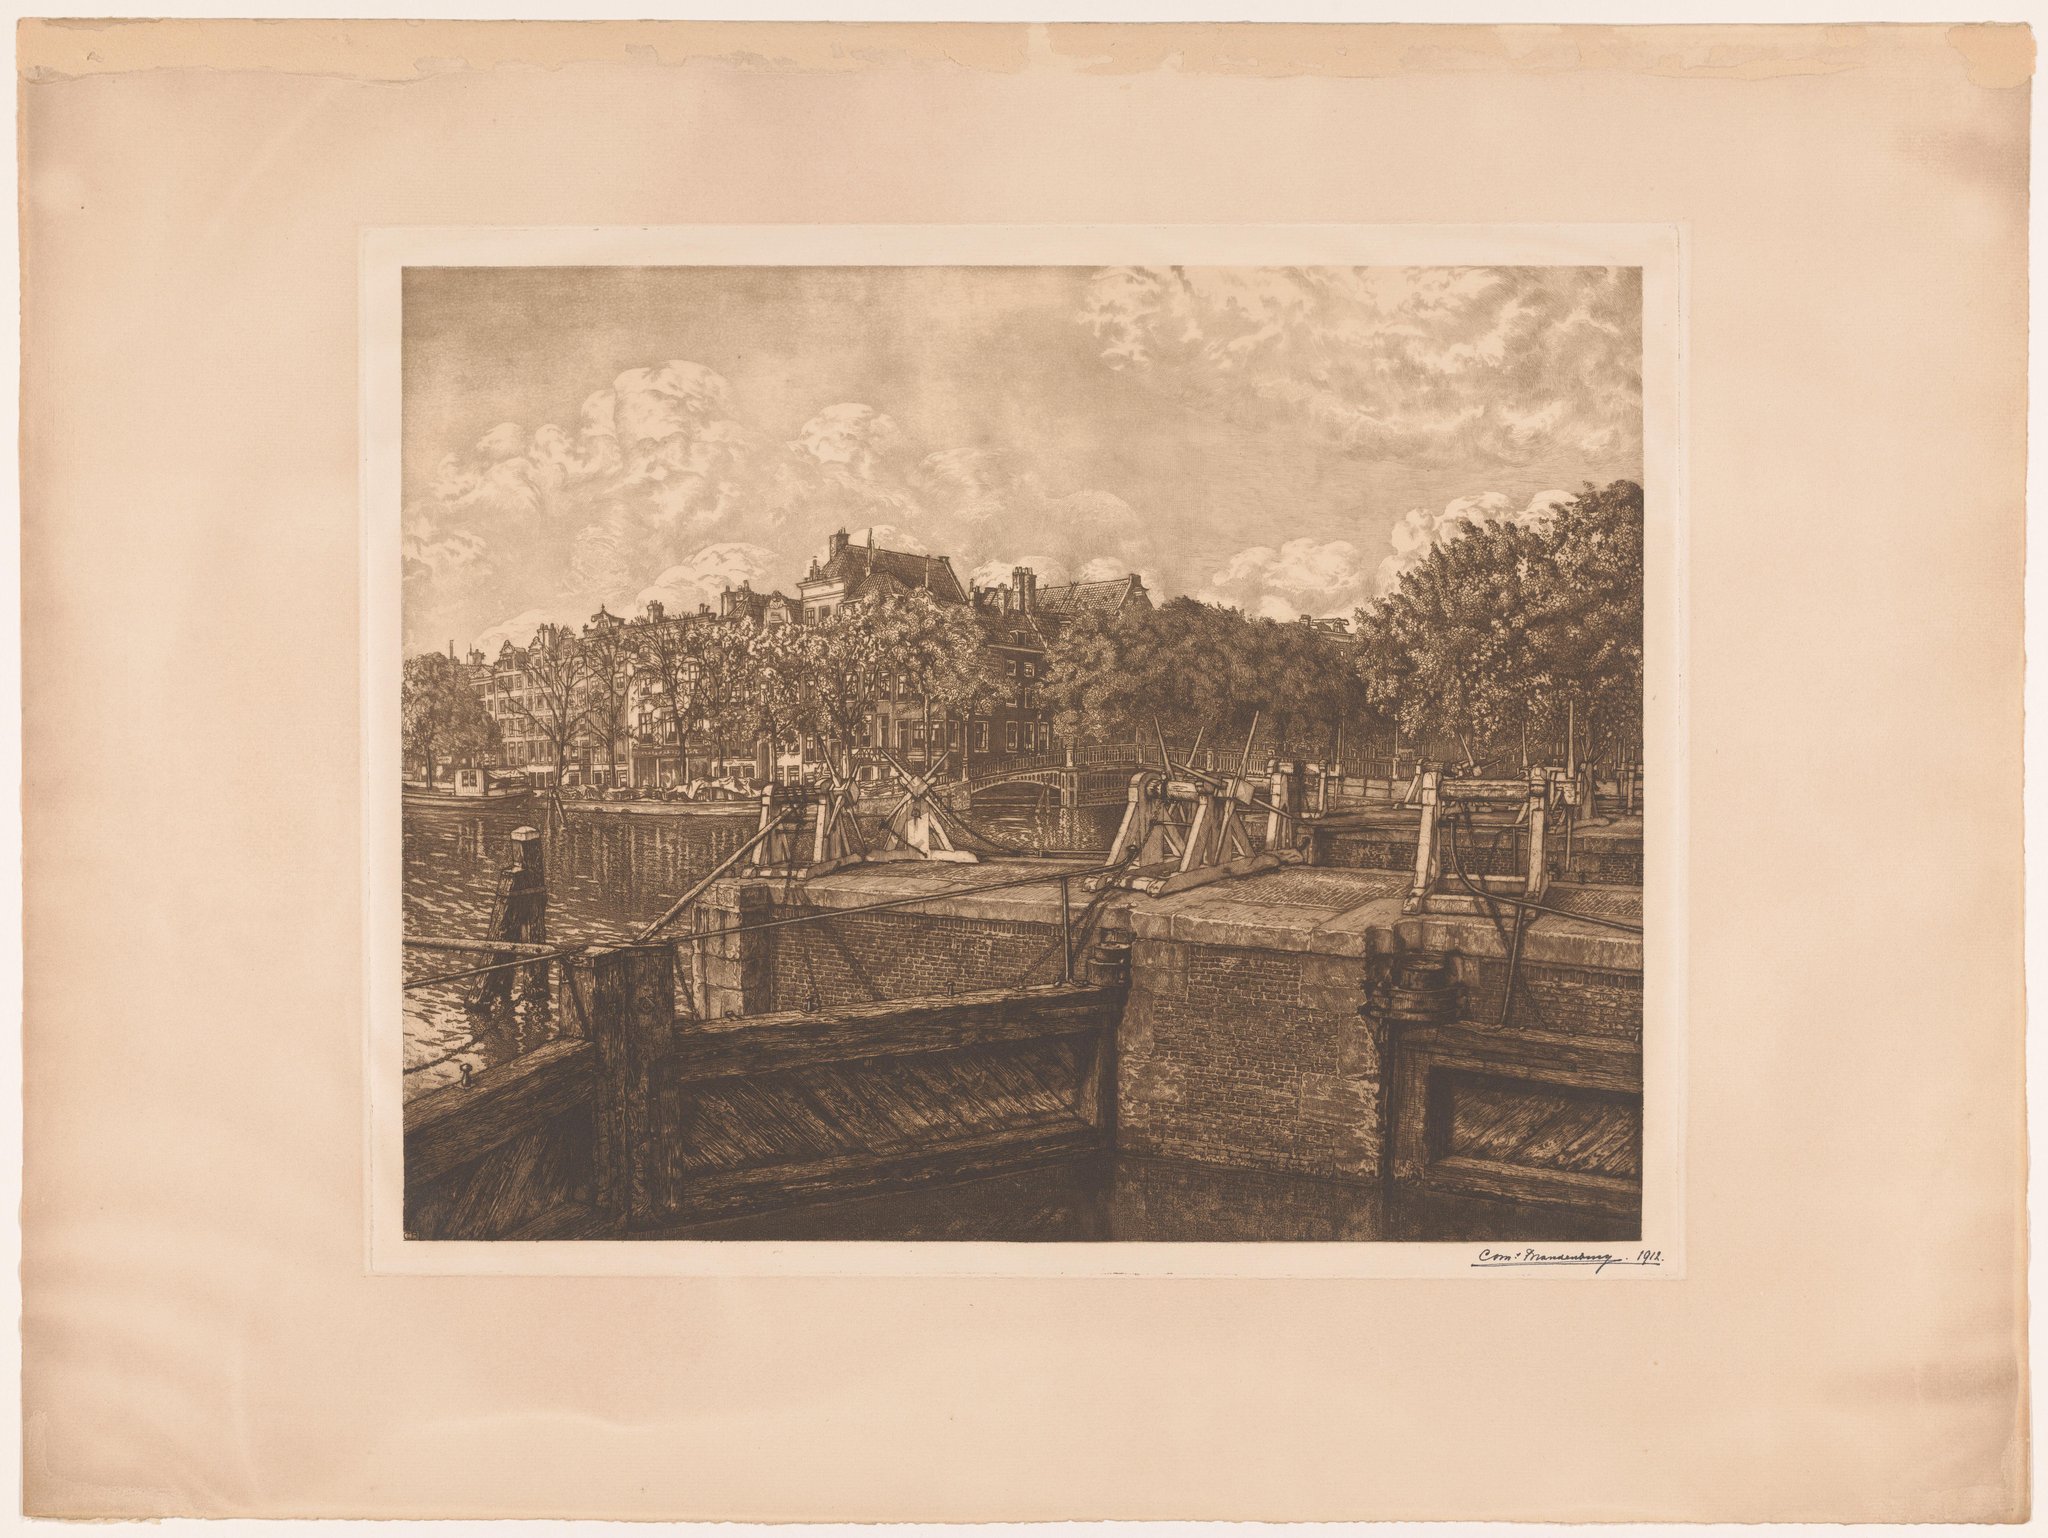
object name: print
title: Amstelsluizen in Amsterdam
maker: cornelis brandenburg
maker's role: print maker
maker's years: 1884-1954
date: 1912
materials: paper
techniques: etching, intaglio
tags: sluice, weir, urban housing, canals, waters (in city)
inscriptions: collector's mark: Lugt 2228, watermark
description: Gezicht op de Amstelsluizen en de hoek van de Amstel en de Nieuwe Prinsengracht.